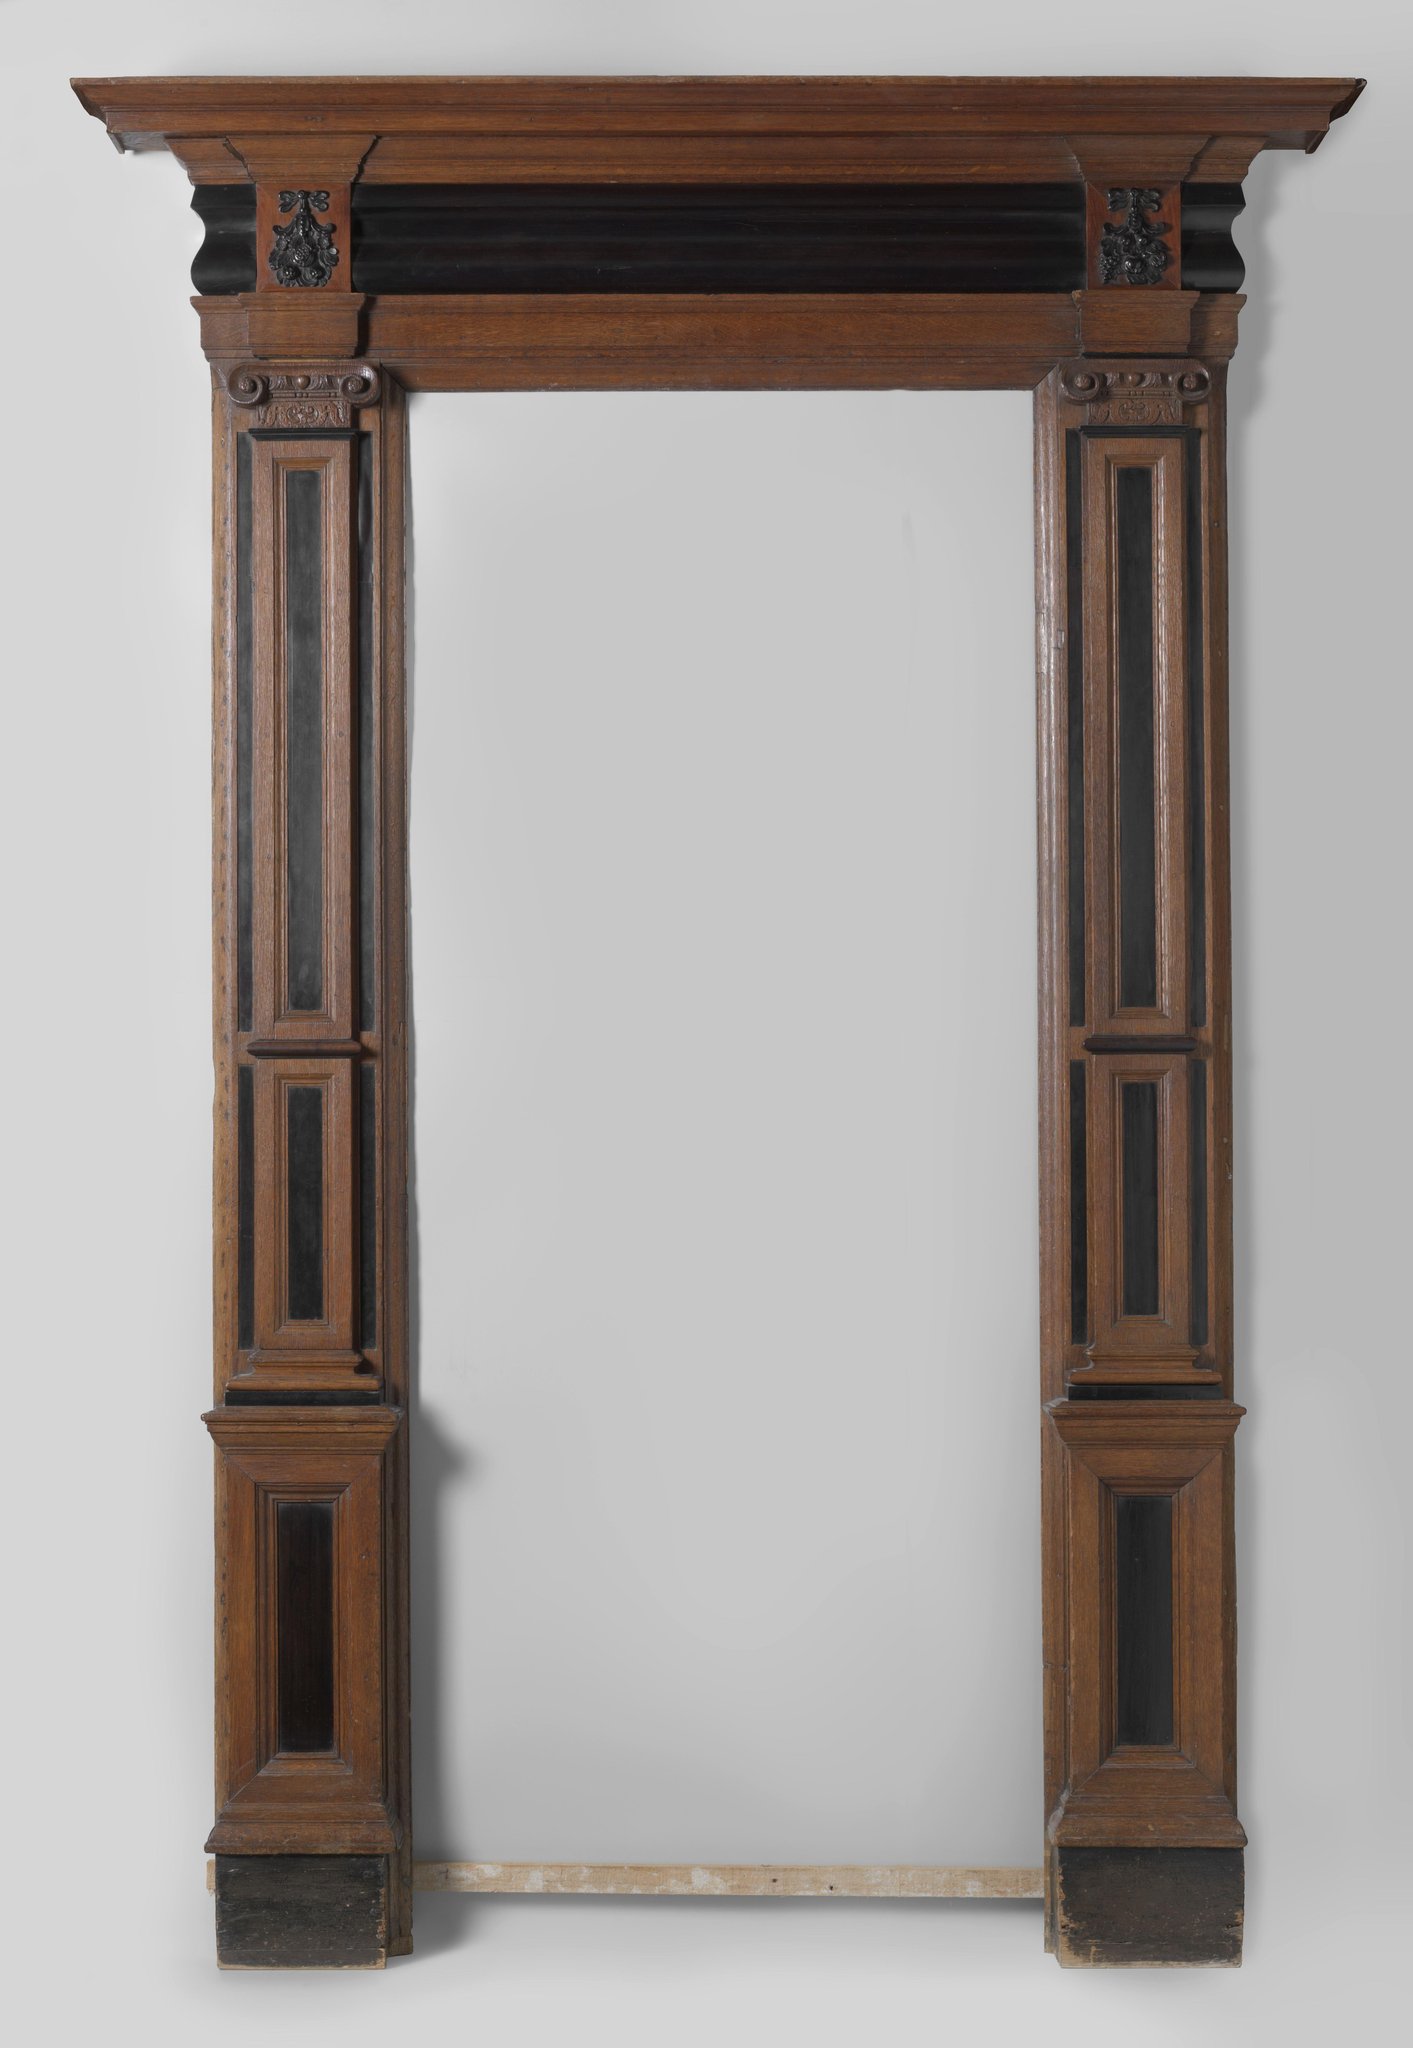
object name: portiek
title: Portiek van eikenhout versierd met ebbenhout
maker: Anonymous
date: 1650-1700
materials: wood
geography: northern netherlands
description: Het portiek heeft op de stijlen pilasters, eveneens belijmd met ebben en bekroond met een Ionisch kapiteel. Met deur (BK-NM-3114-2).